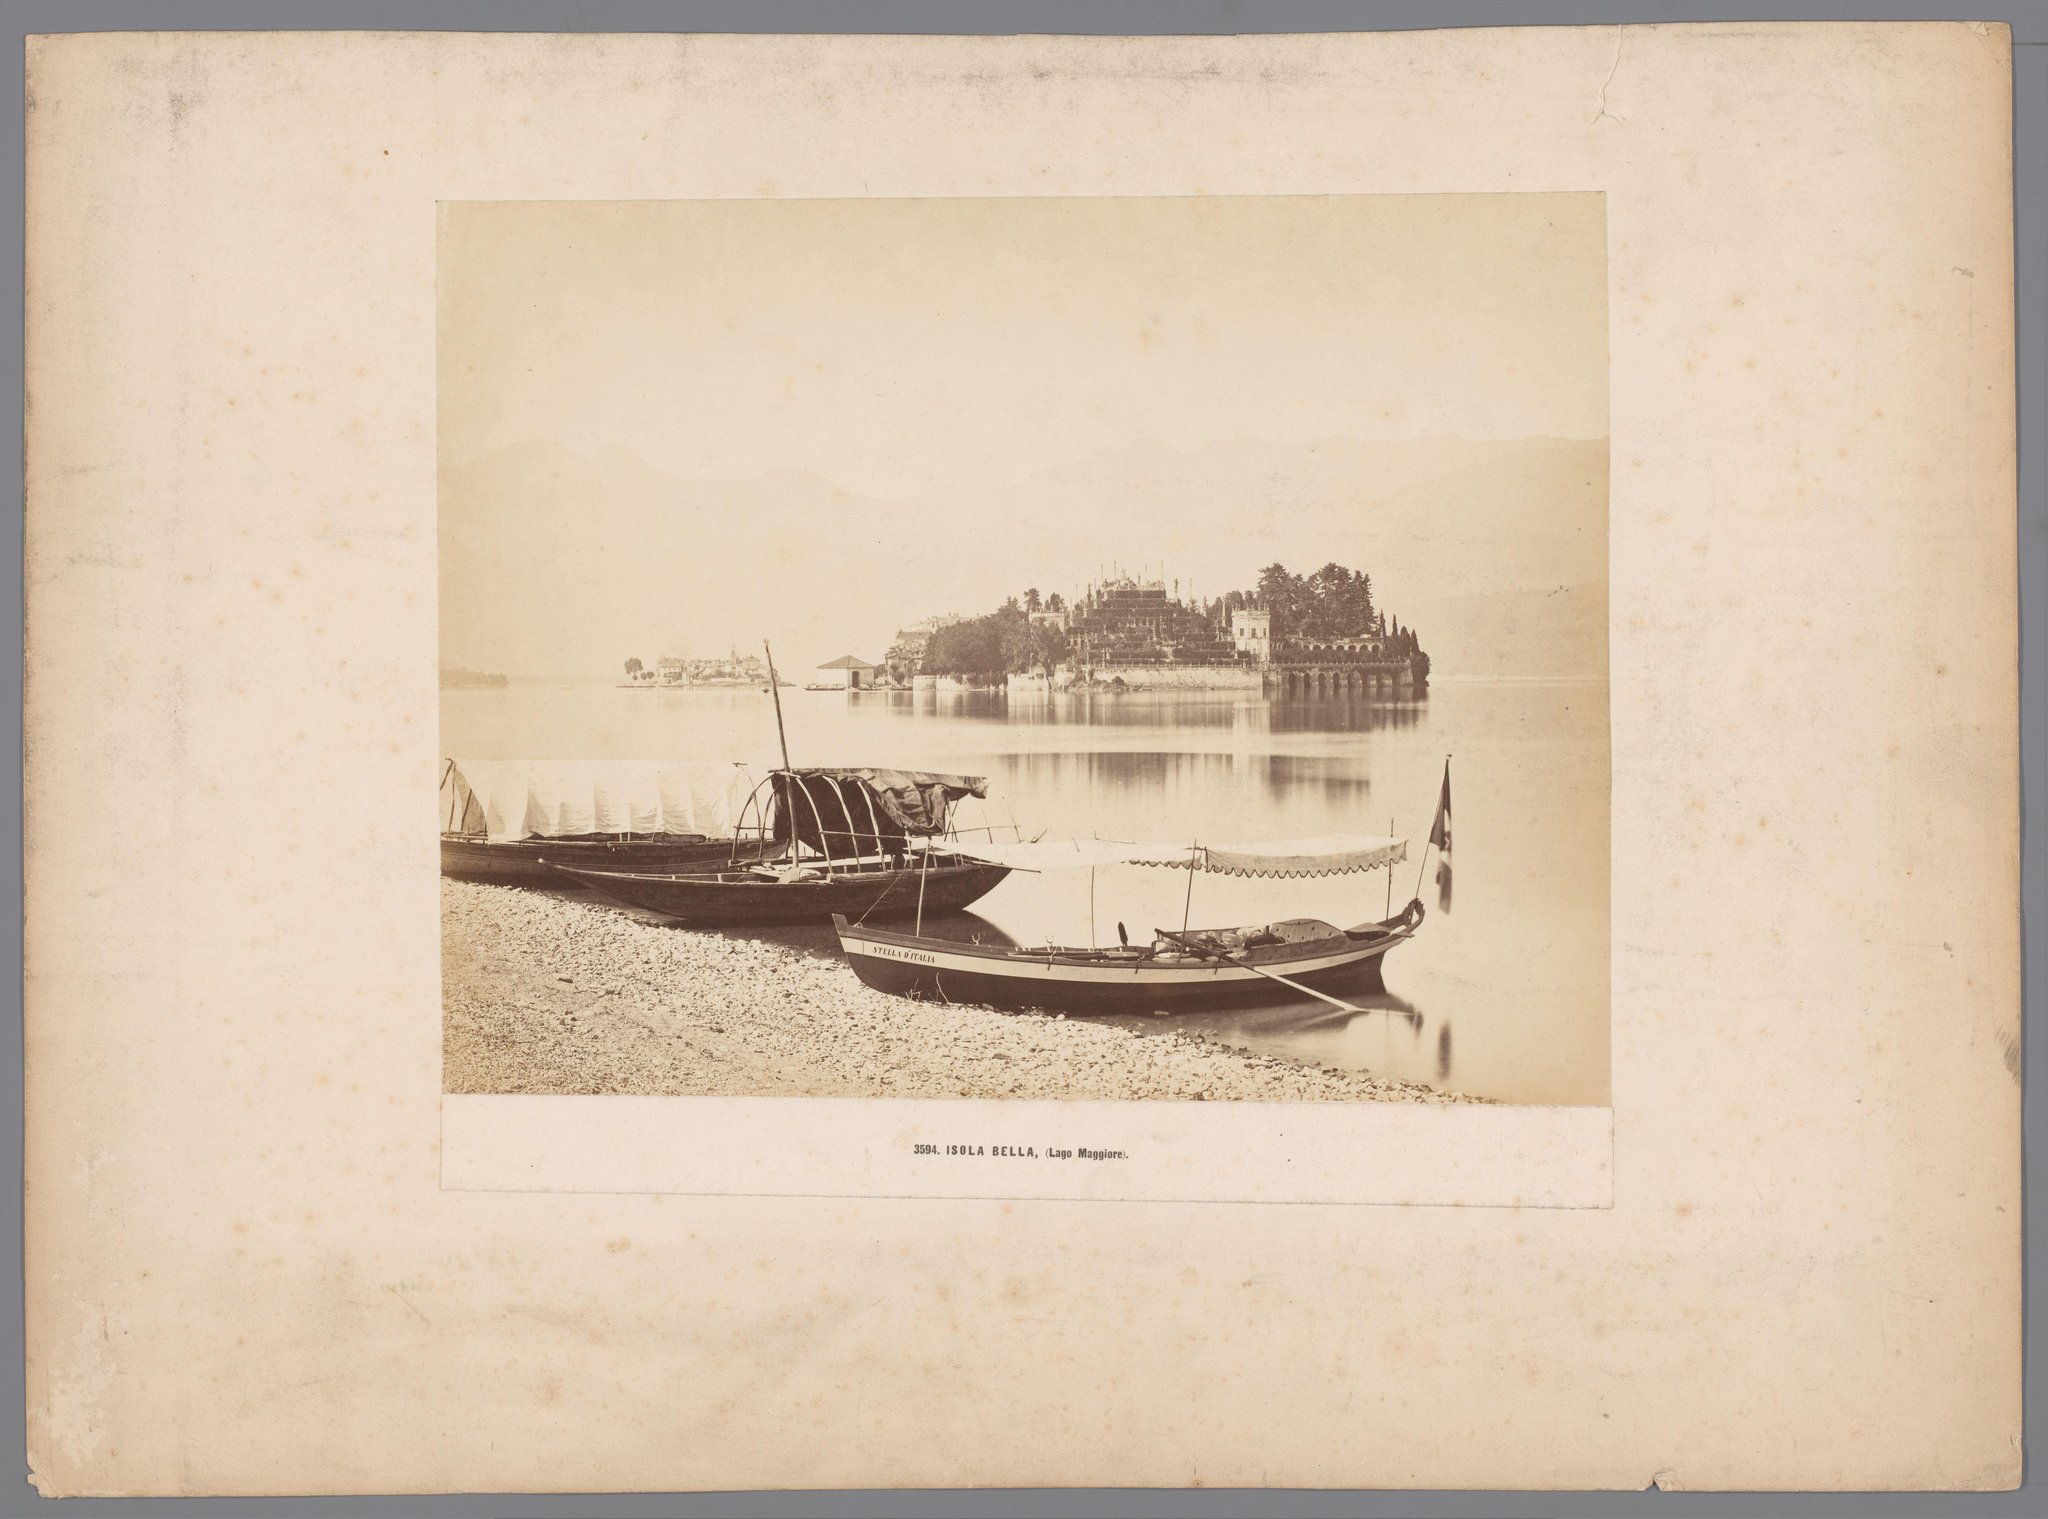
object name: photograph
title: Gezicht op Isola Bella in het Lago Maggiore, Italië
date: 1862-1890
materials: cardboard, paper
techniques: albumen print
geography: lake maggiore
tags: island, rowing-boat, canoe, etc.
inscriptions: number: ‘3594.’, inscription: ‘(+) alinari’